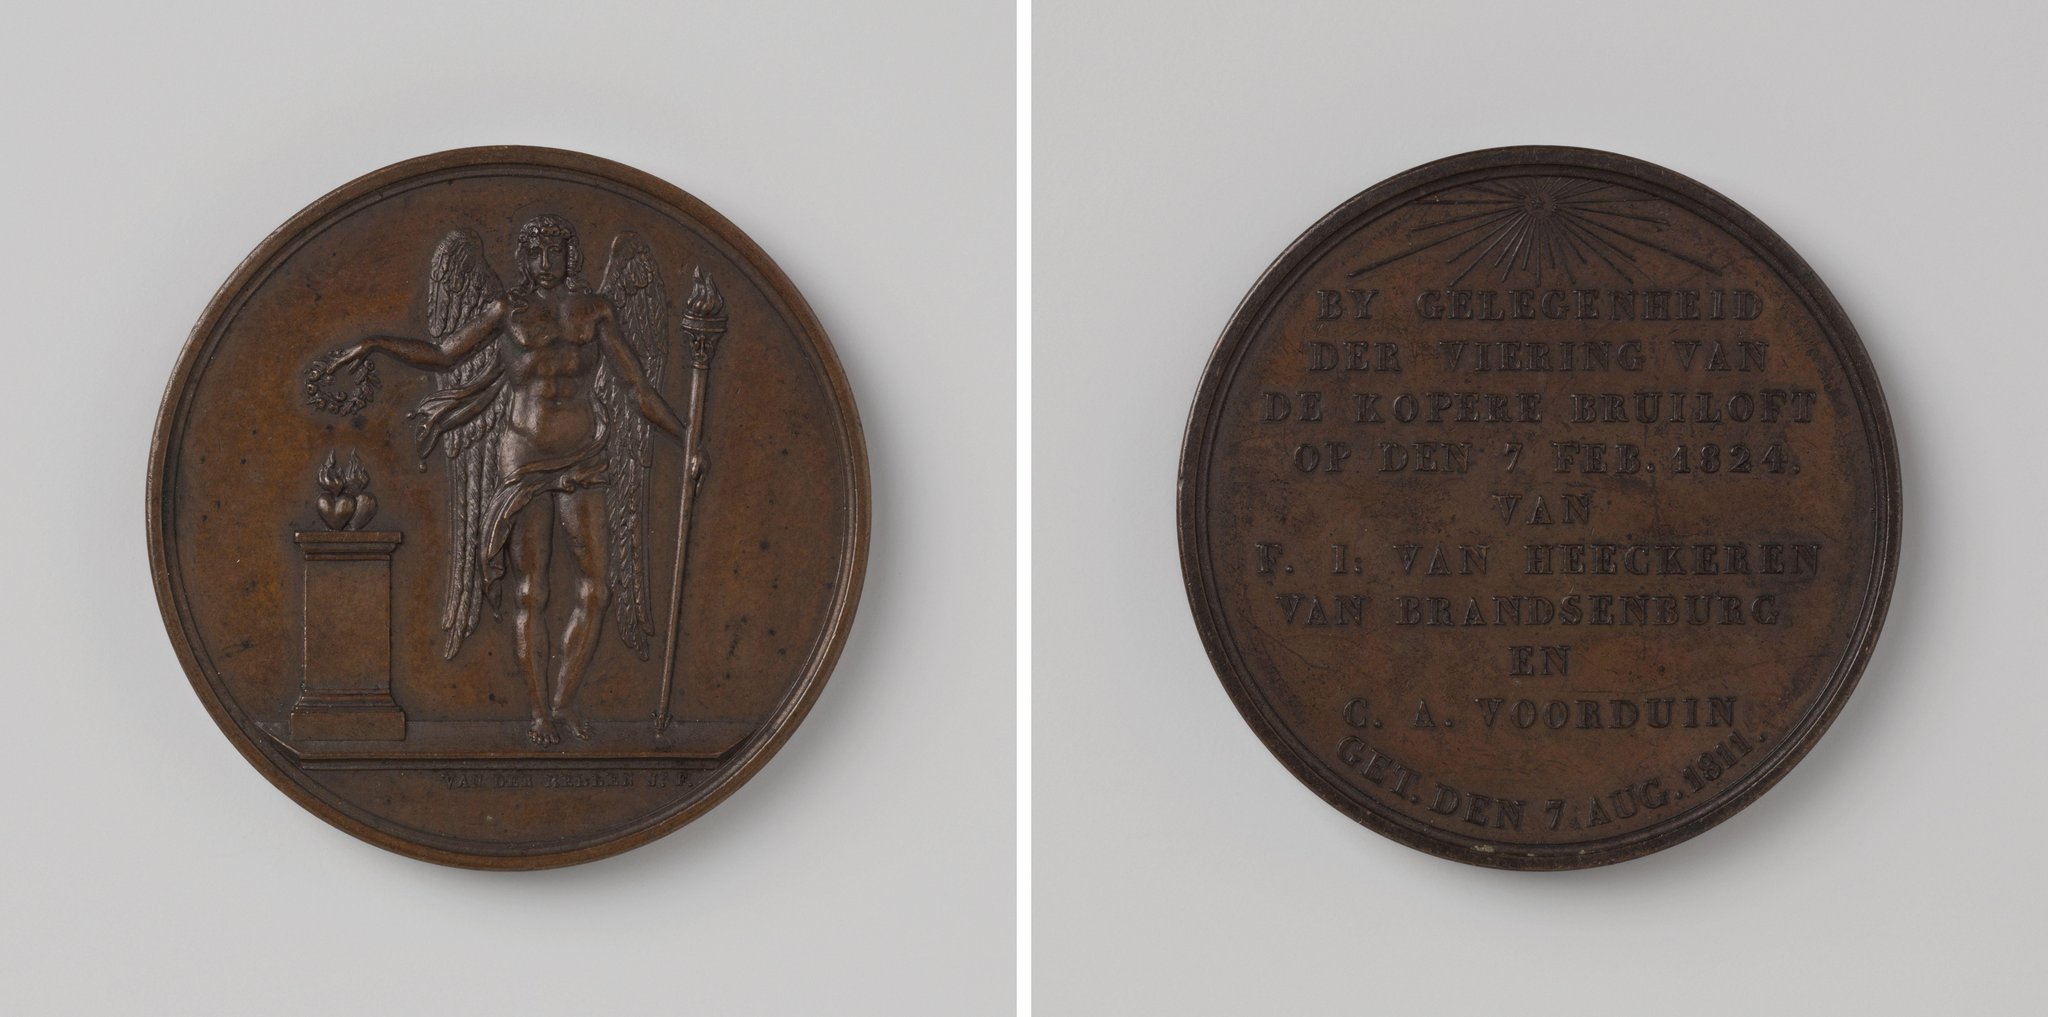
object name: marriage medal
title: Twaalfeneenhalfjarig huwelijk van F.I. van Heeckeren van Brandsenburg en C.A. Voorduin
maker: david van der kellen (1804-1879)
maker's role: die cutter, draughtsman, print maker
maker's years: 1804-1879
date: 1824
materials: bronze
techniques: striking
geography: utrecht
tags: frans jan baron van heeckeren van brandsenburg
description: Bronzen penning. Voorzijde: gevleugelde huwelijksgod Hymen houdt in linkerhand brandende toorts en legt met rechterhand rozekrans op altaar, waarop twee verbonden brandende harten liggen; afsnede: signatuur. Keerzijde: opschrift onder hemellicht. Jubileumpenning ter ere van twaalfeneenhalfjarig huwelijk.